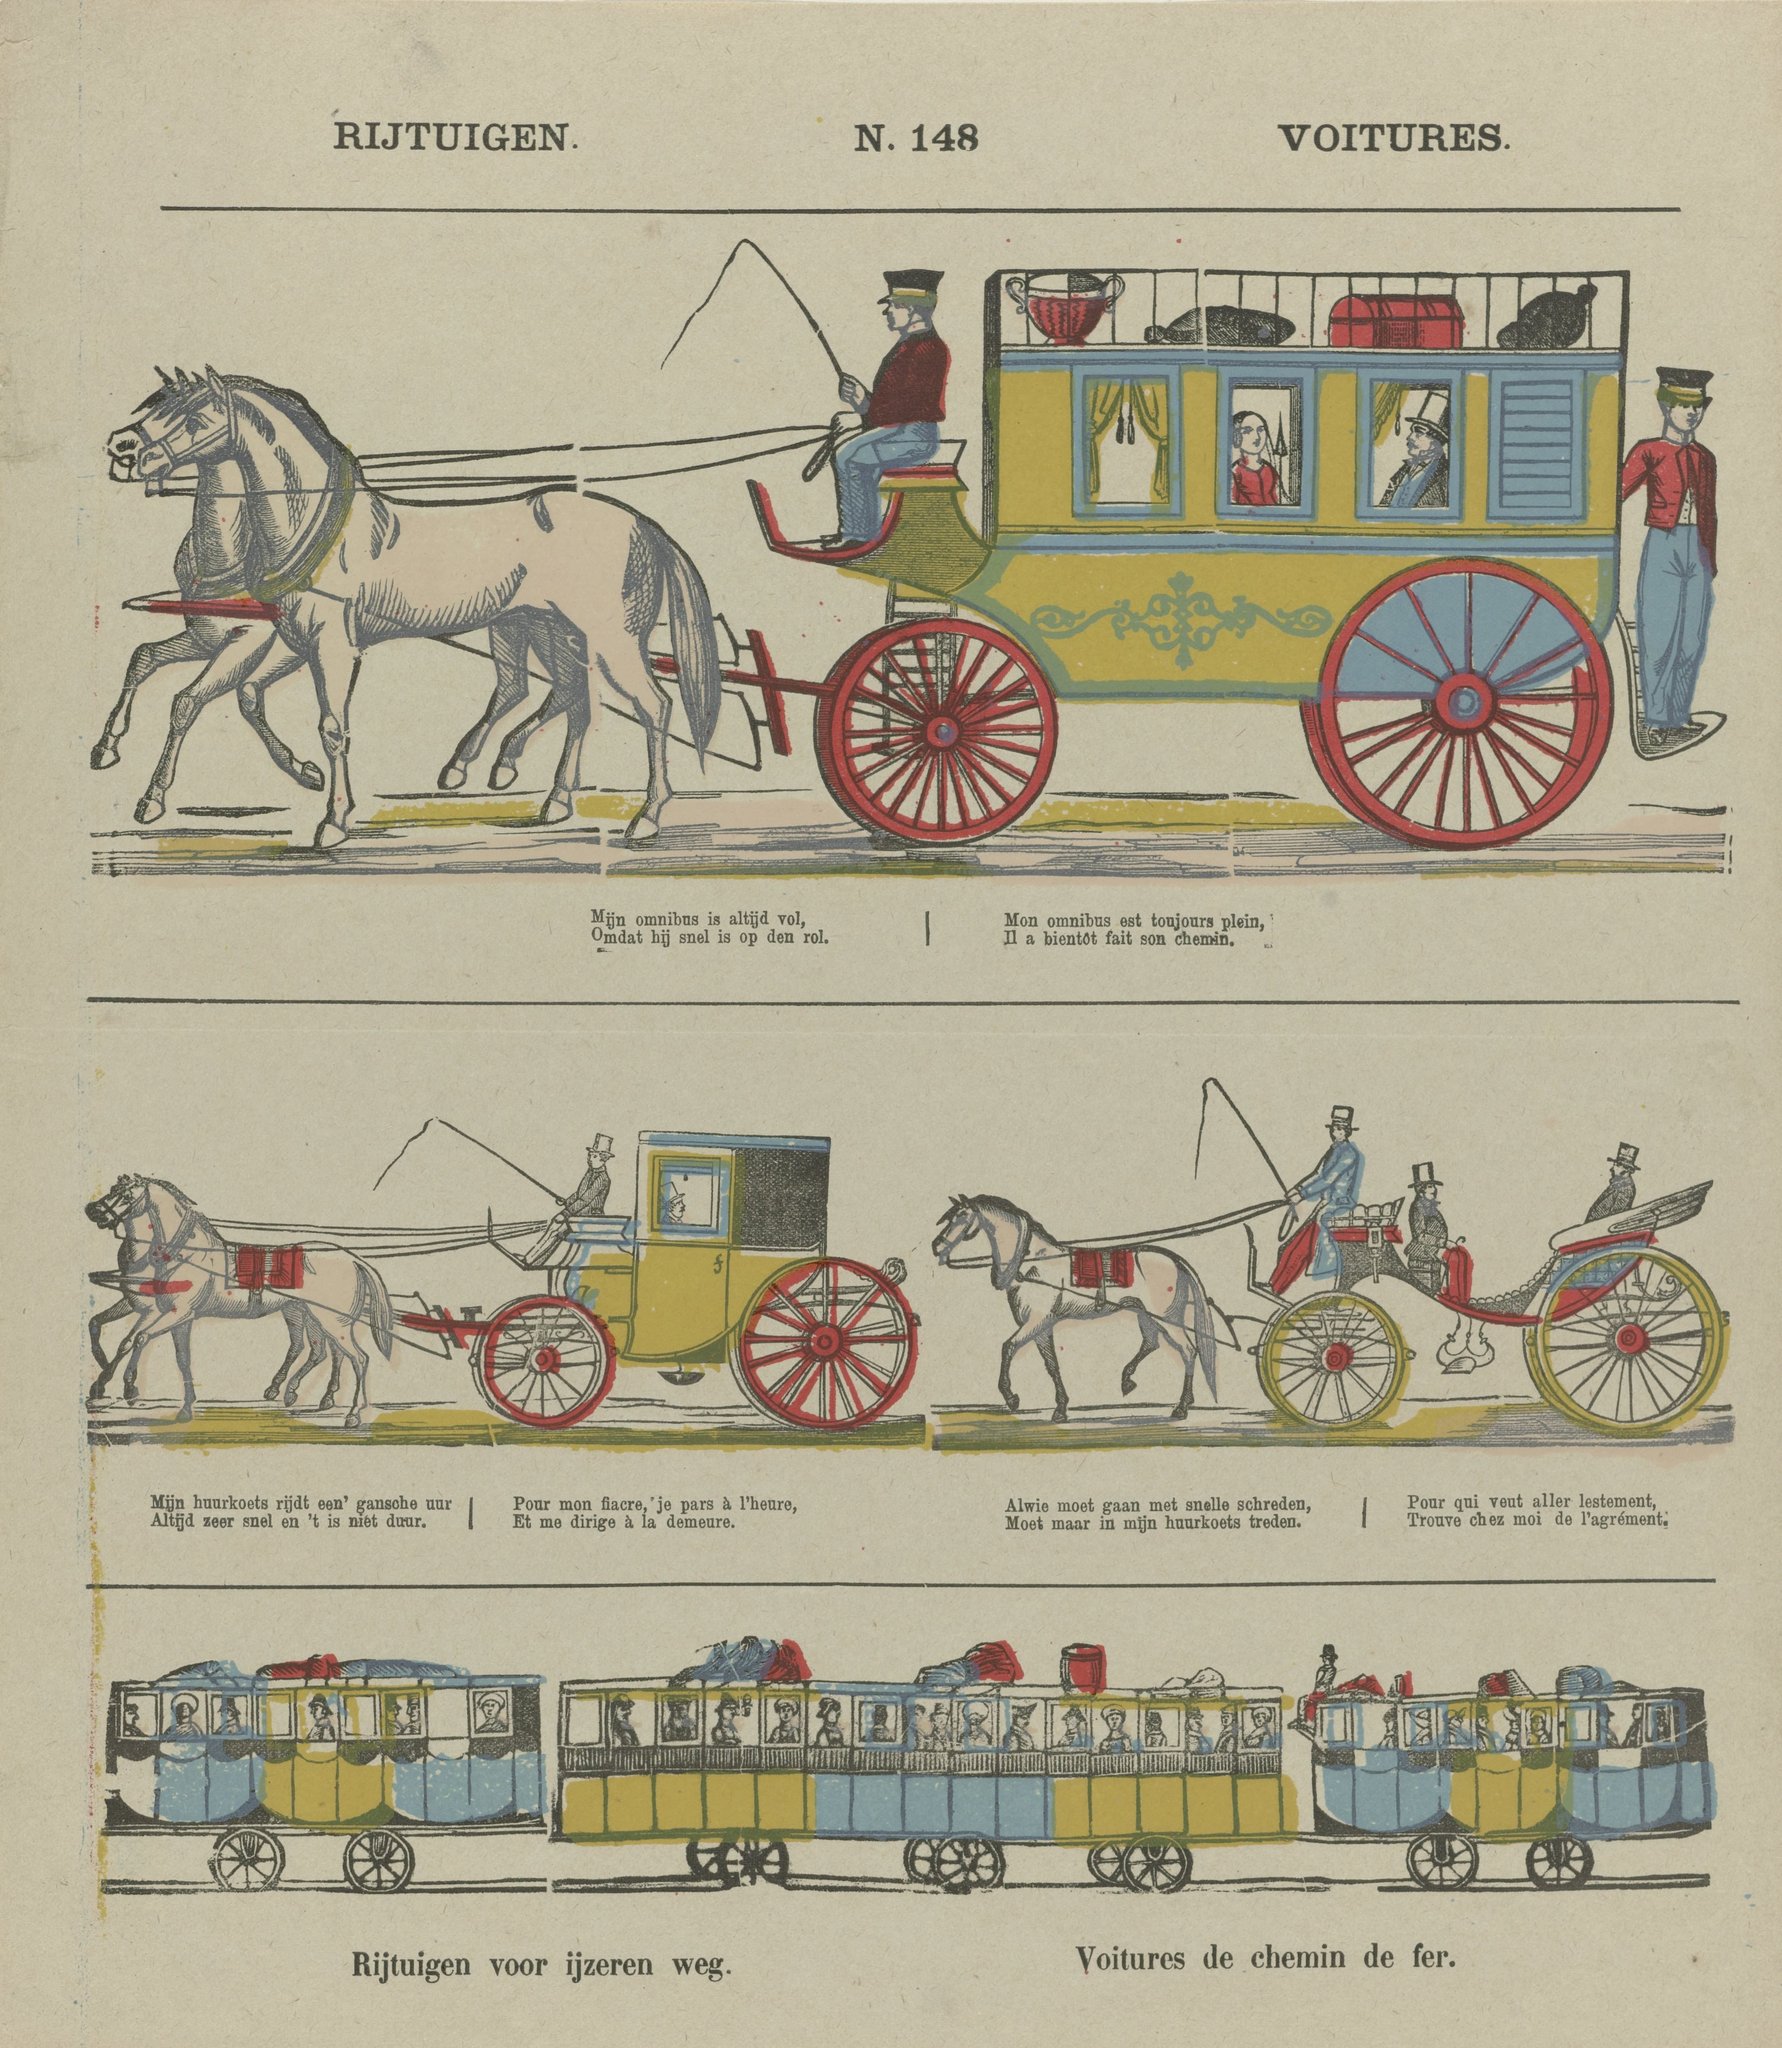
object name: popular print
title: Rijtuigen / Voitures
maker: Anonymous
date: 1833-1911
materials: paper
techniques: lithograph, letterpress printing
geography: turnhout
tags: passenger train, four-wheeled, animal-drawn vehicle, e.g.: cab, carriage, coach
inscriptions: collector's mark: Lugt 2760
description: Blad met 3 horizontale rijen met in totaal 4 voorstellingen van verschillende rijtuigen en een personentrein. Onder elke afbeelding een onderschrift in het Nederlands en in het Frans in twee kolommen. Genummerd midden boven: N. 148.